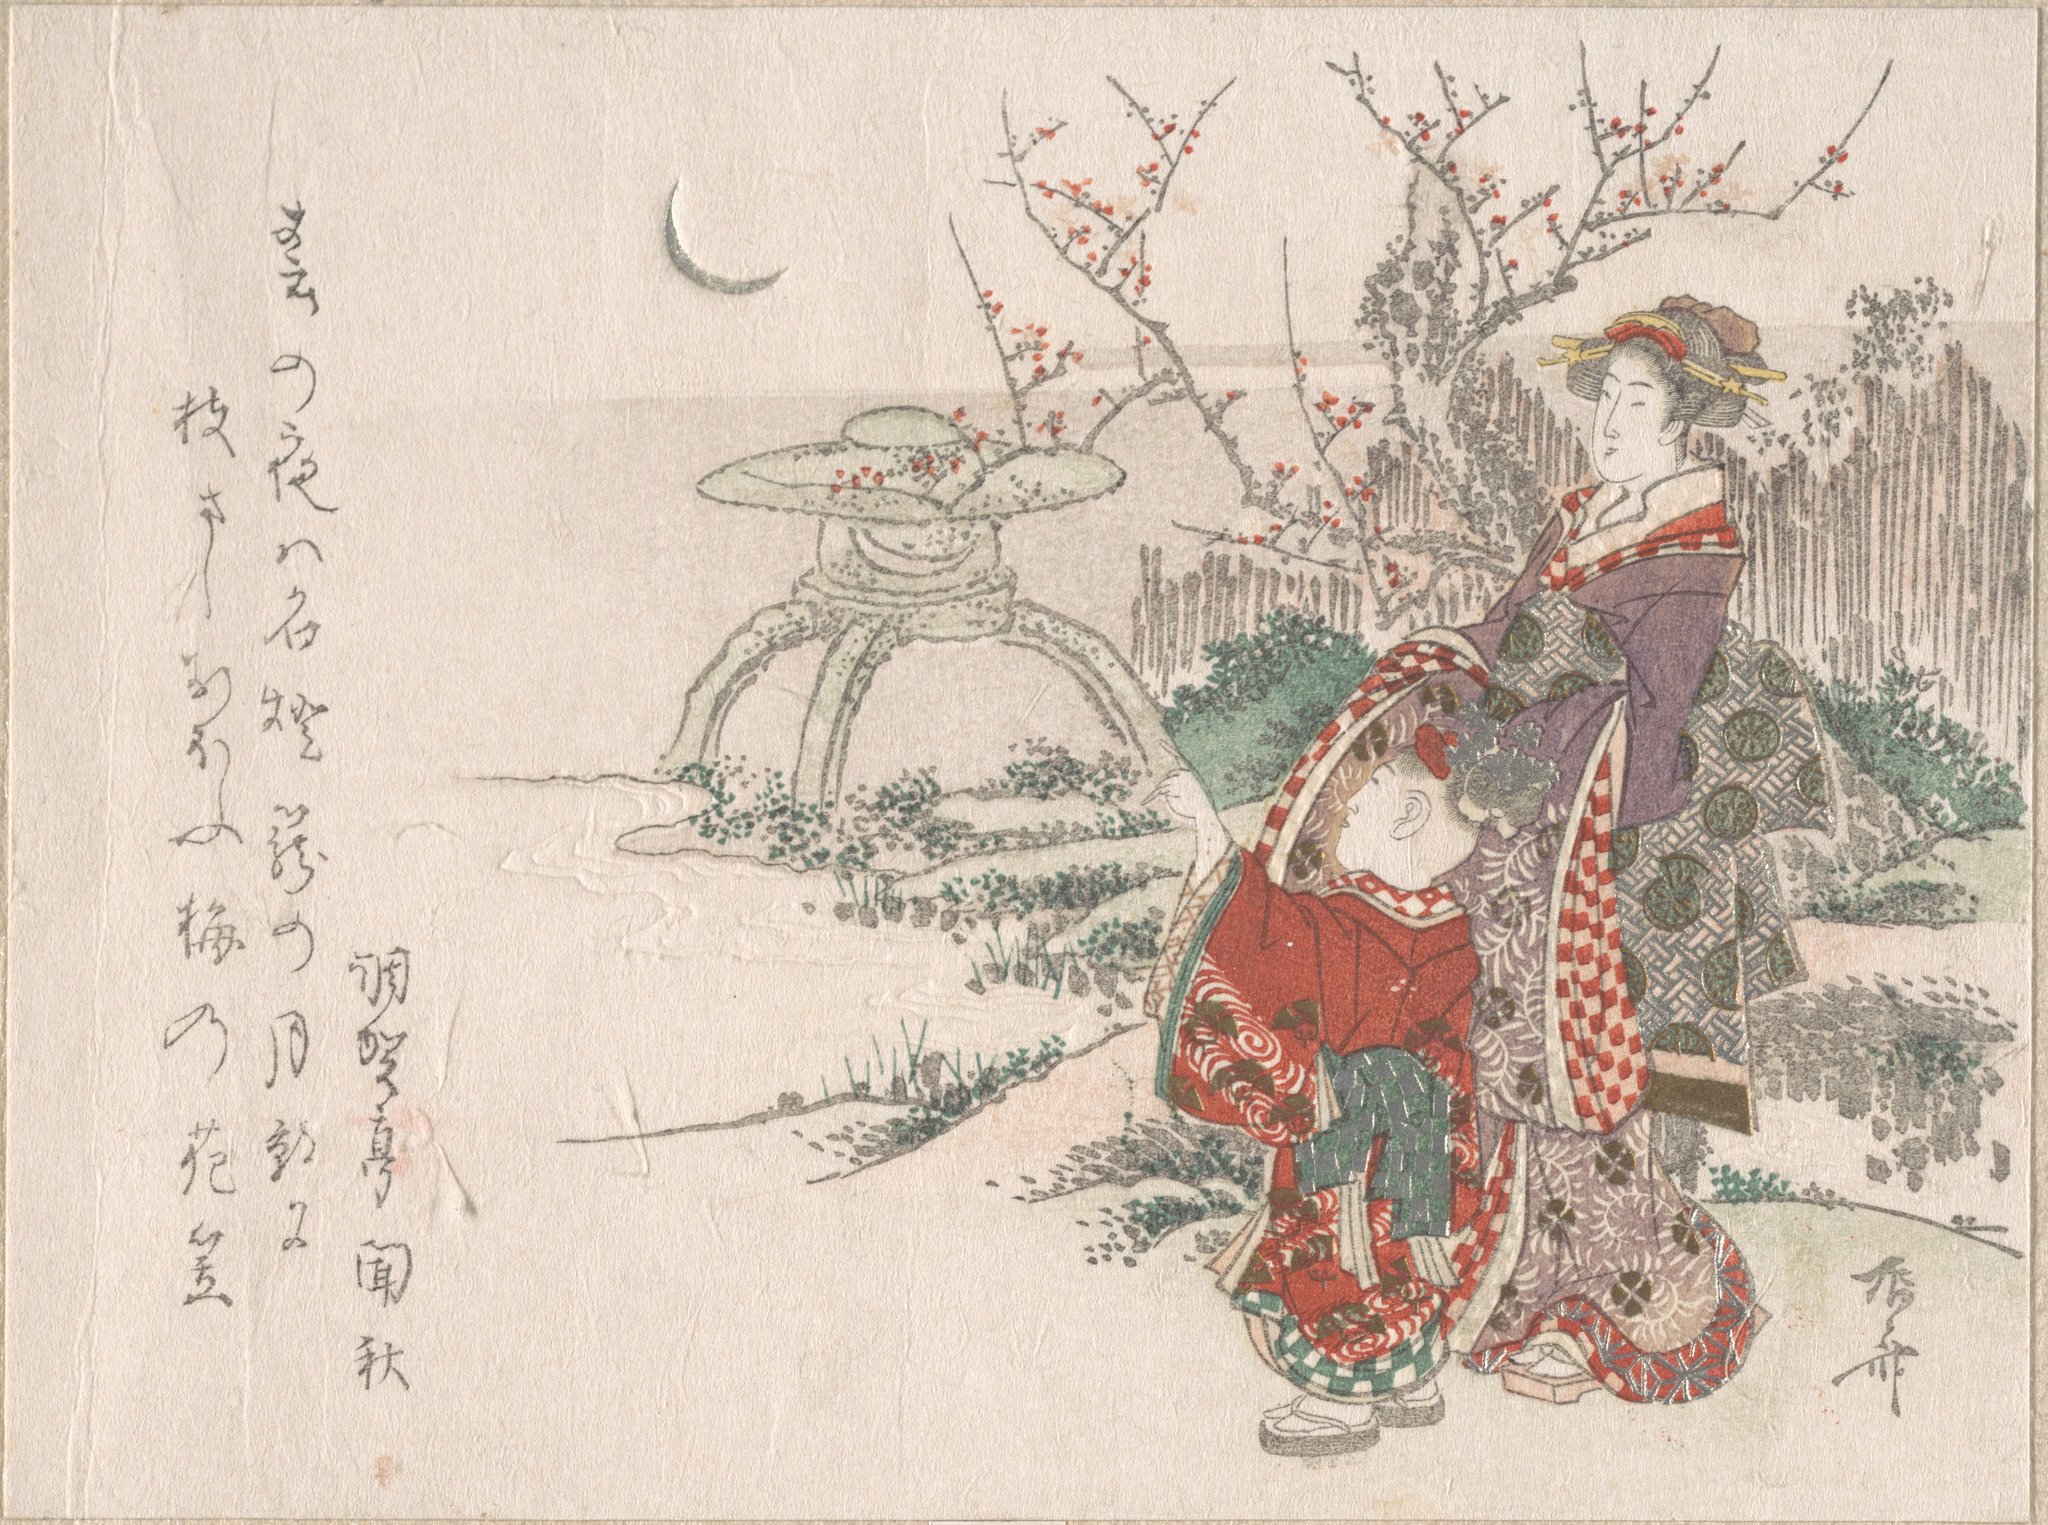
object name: print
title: Woman with a Child in the Garden Looking at the New Moon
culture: japanese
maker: ryūryūkyo shinsai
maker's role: artist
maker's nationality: japanese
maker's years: 1799-1823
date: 1801-1900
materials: ink, paper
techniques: surimono, woodblock print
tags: gardens,women,moon,trees